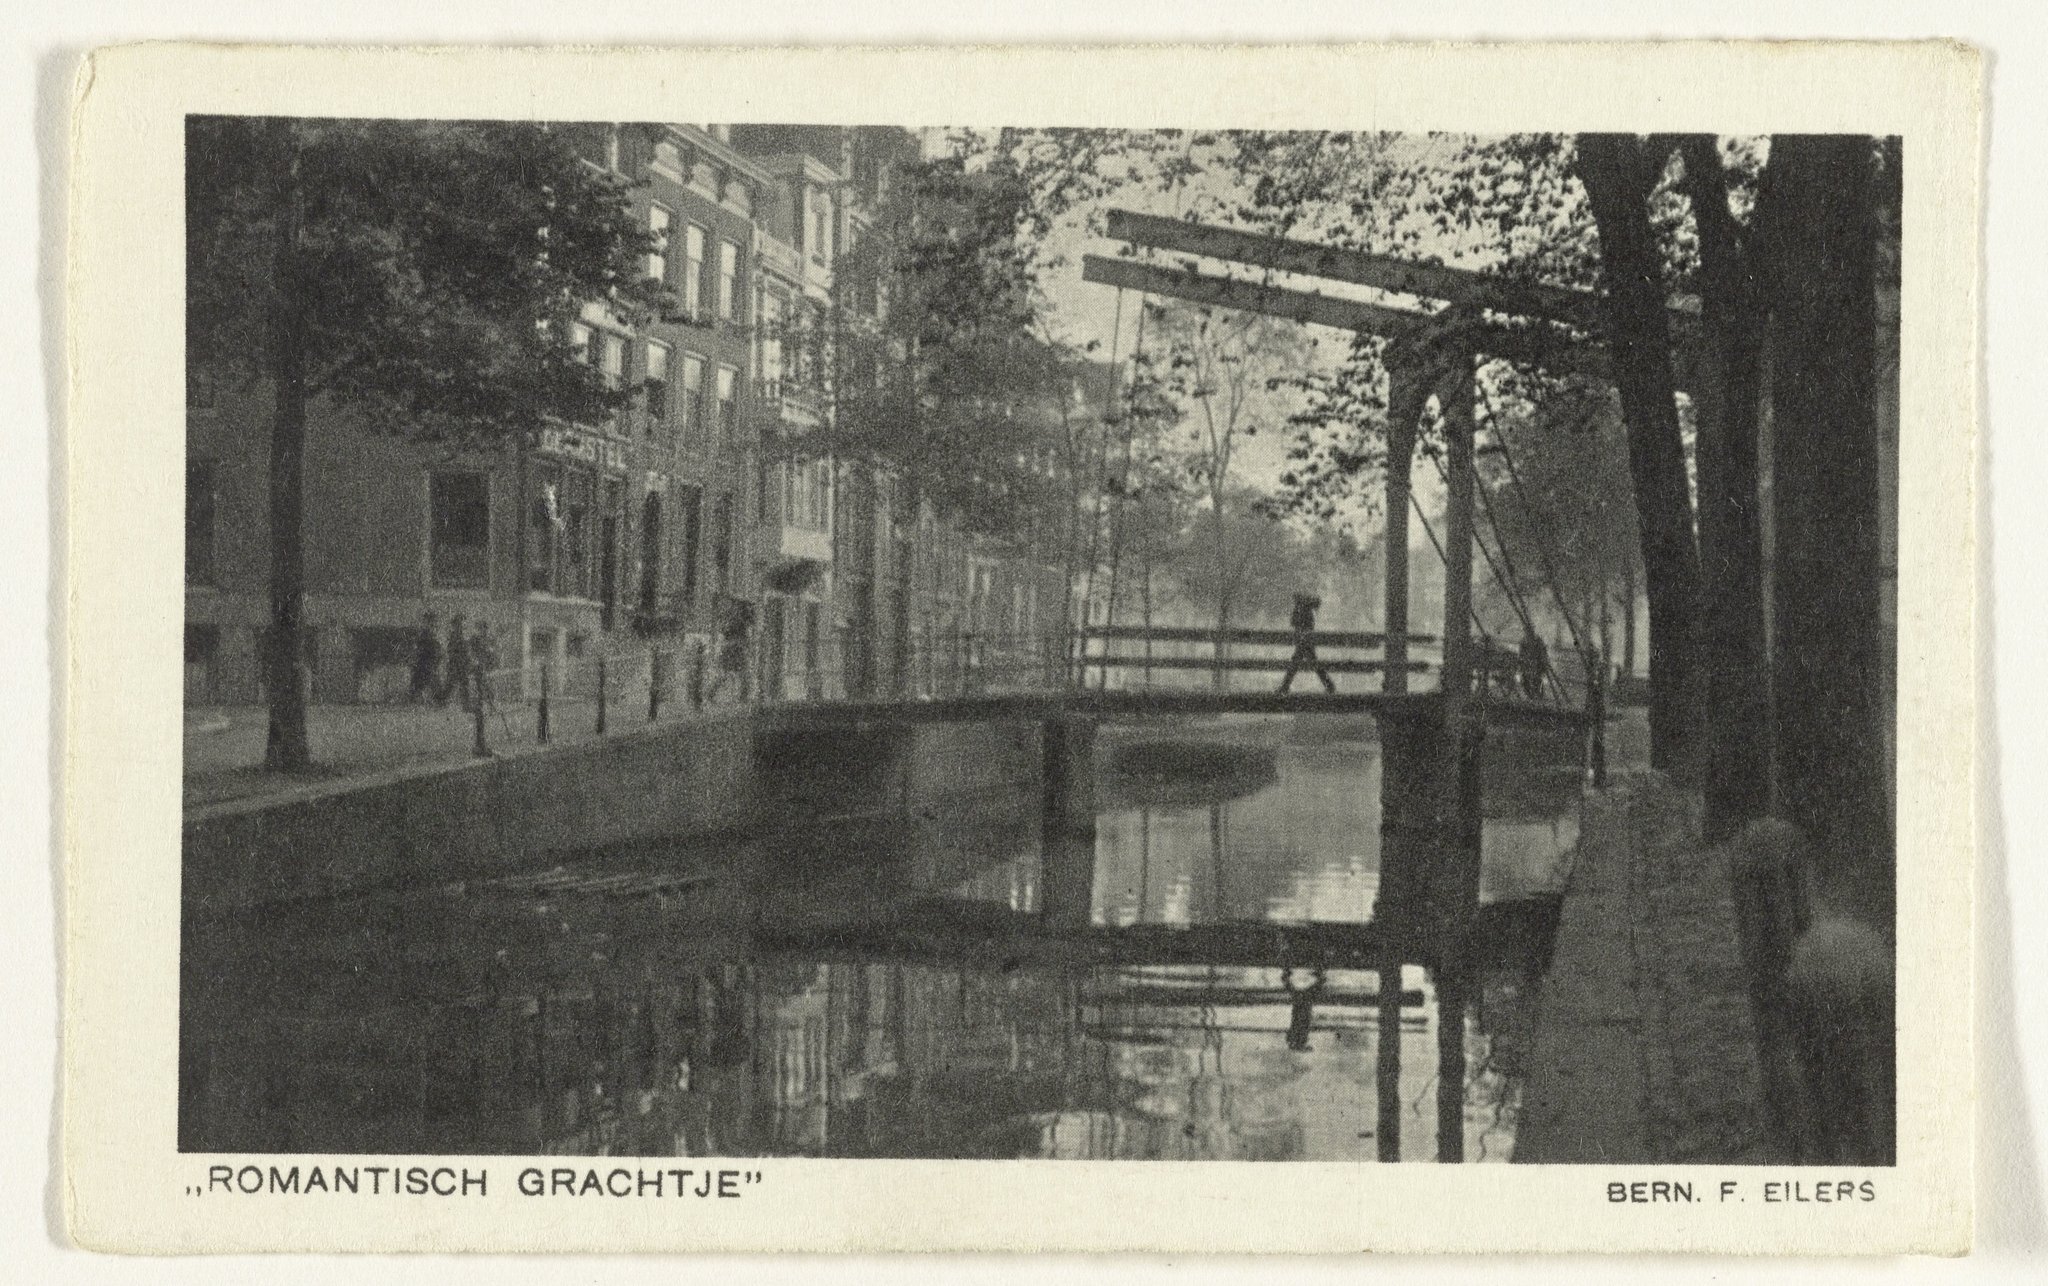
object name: ansichtkaart, prentbriefkaart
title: Groenburgwal, Amsterdam ("Romantisch grachtje")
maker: bernard eilers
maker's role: fotograaf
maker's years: 1878-1951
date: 1913-1940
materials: paper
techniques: rotogravure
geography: amsterdam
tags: canals, waters (in city)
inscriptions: name: ‘Bern. F. Eilers’, annotation: ‘Eilers Artistieke kaarten - uitg.-mij. "Kosmos" - Amsterdam’, annotation: ‘Serie B Groenburgwal, Amsterdam ("Romantisch grachtje")’